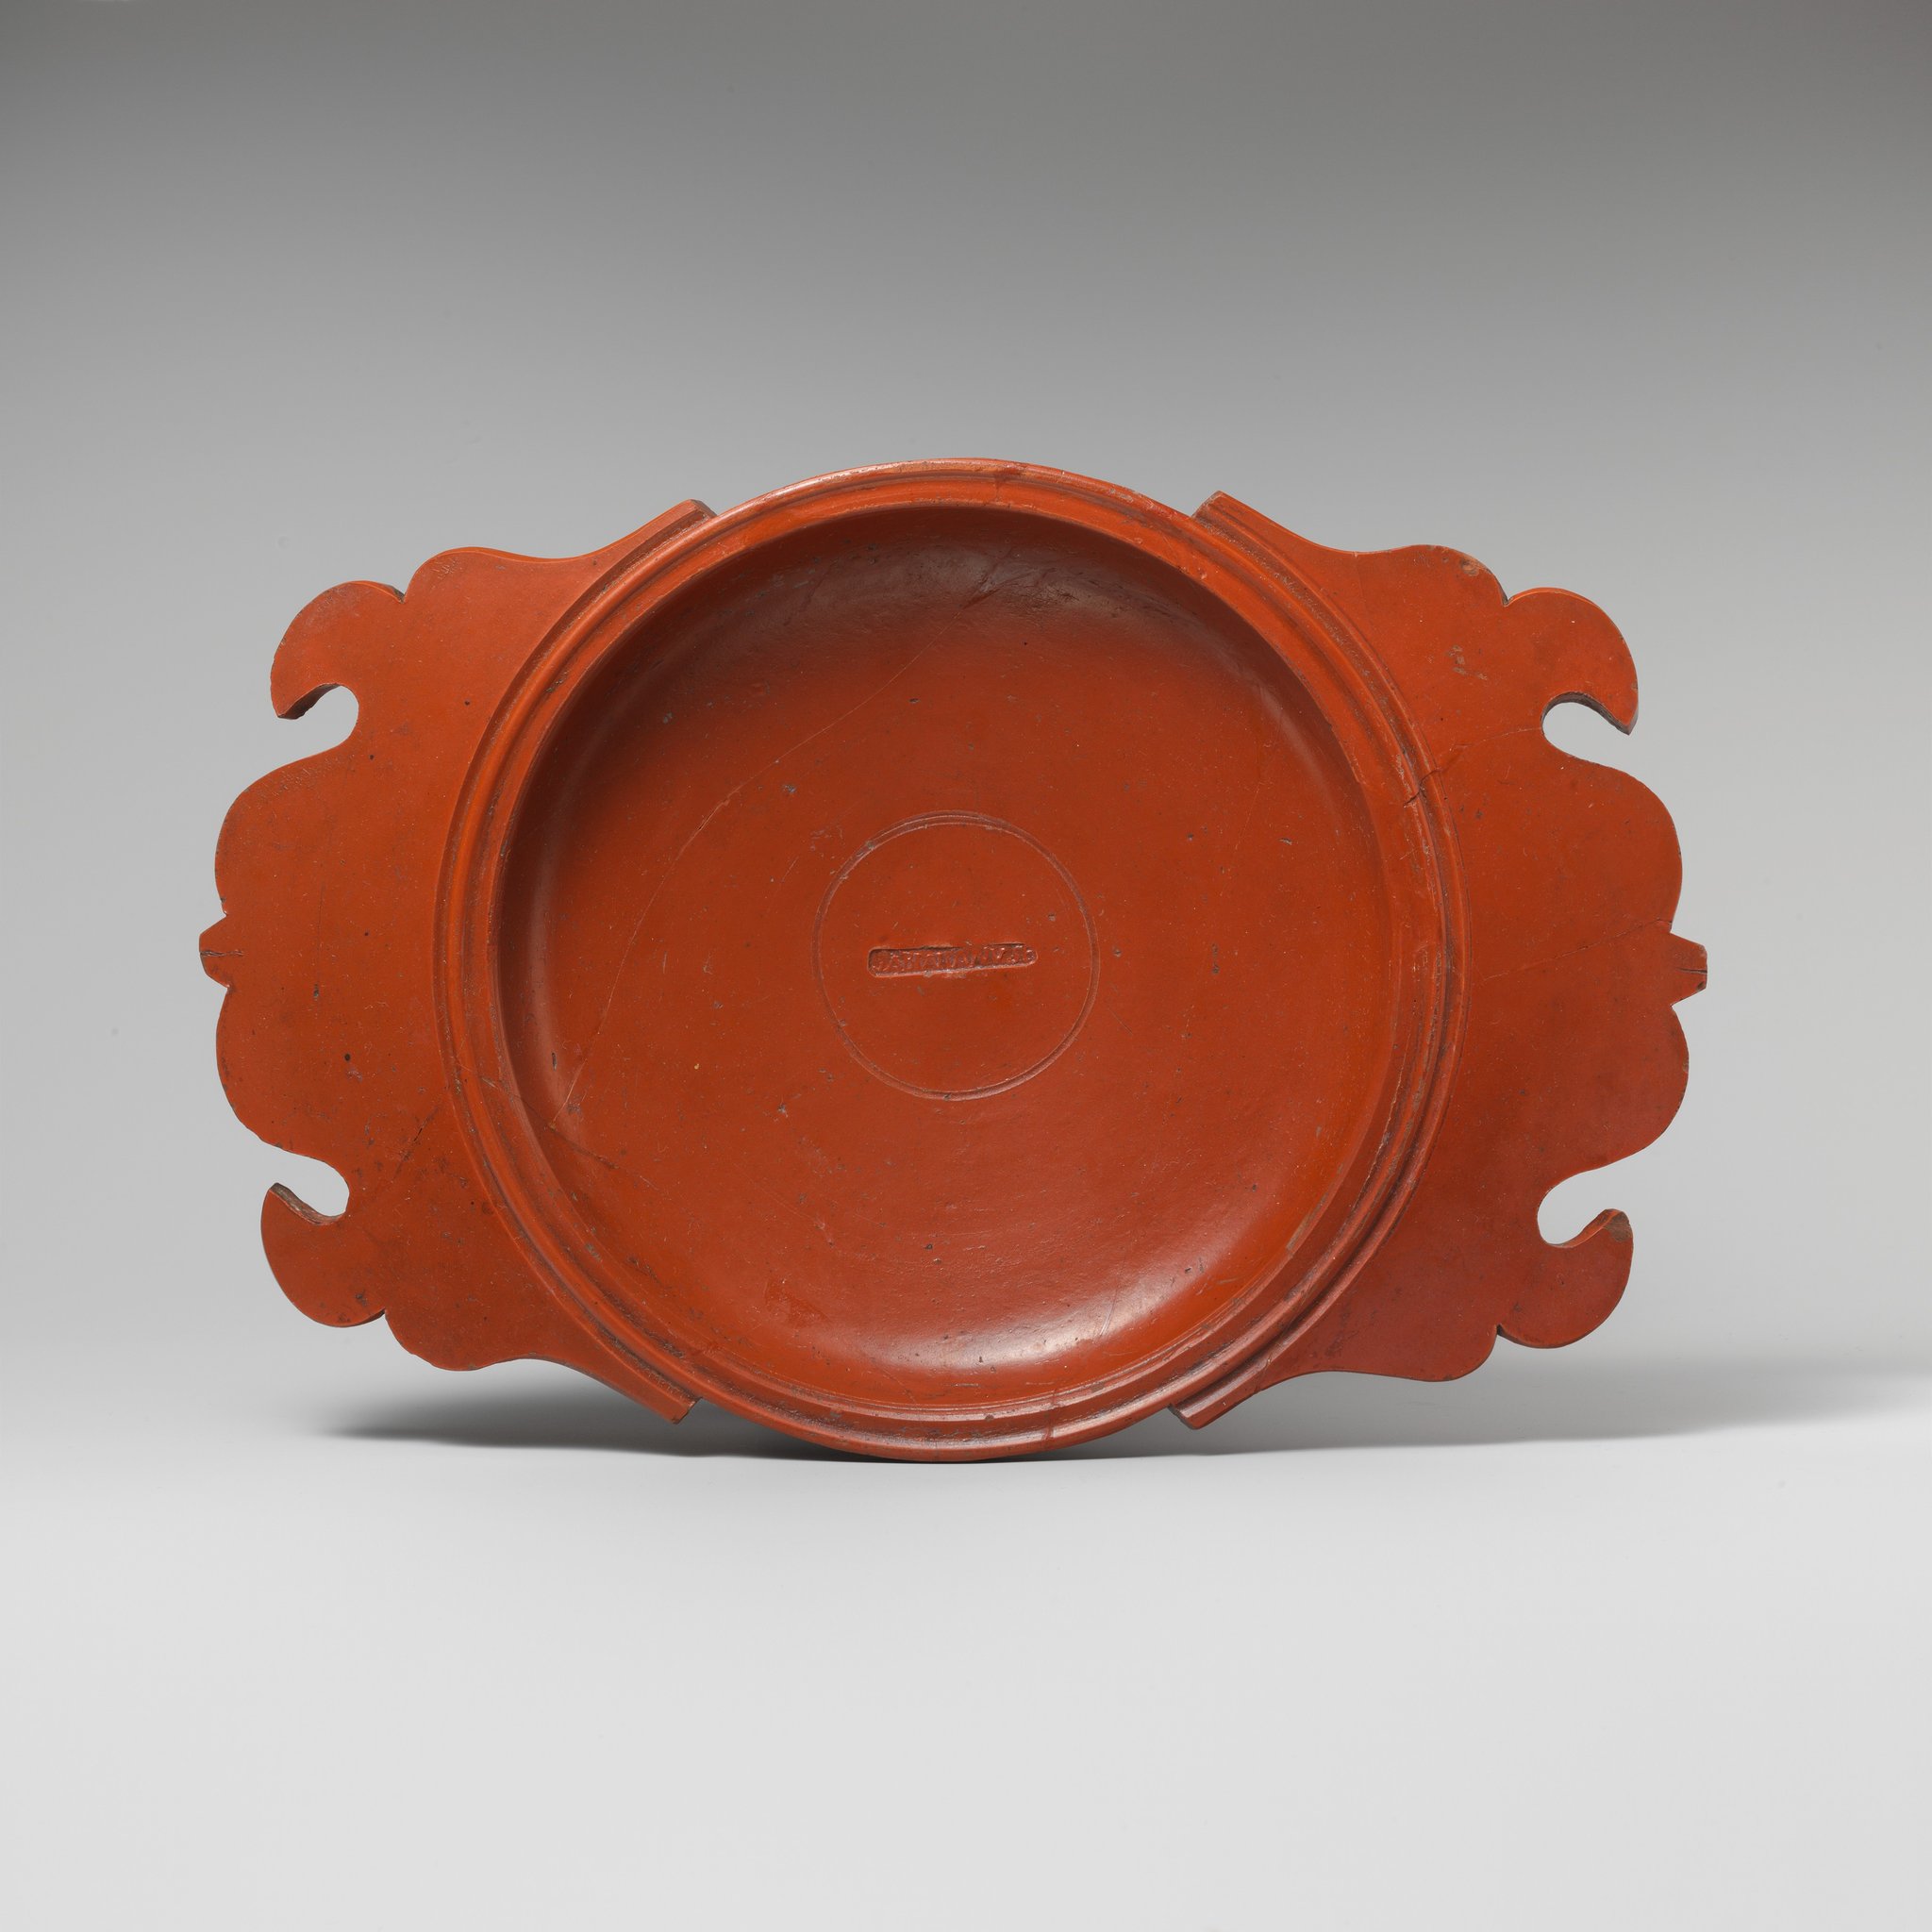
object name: plate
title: Terracotta plate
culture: roman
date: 134-166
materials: terracotta